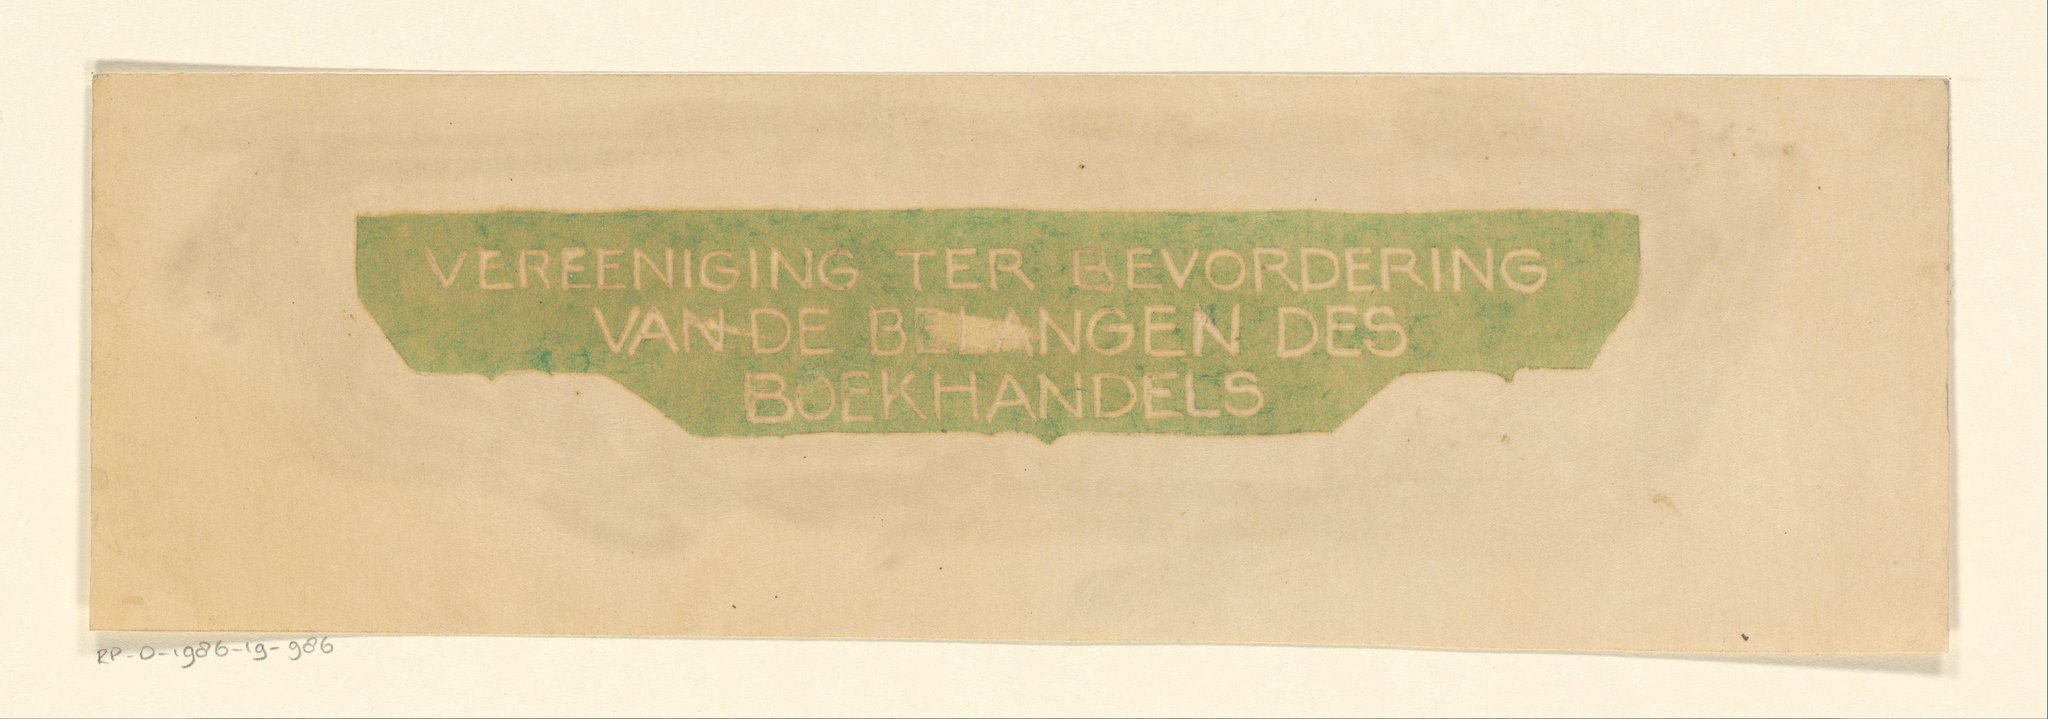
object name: print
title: Ontwerp voor een beeldmerk van de Vereniging ter Bevordering van de Belangen des Boekhandels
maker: reinier willem petrus de vries (1874-1953)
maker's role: draughtsman, print maker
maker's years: 1874-1953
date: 1884-1952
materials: paper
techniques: lithograph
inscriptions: collector's mark: ‘R:MVS.’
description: Beeldmerk bedoeld voor boven een kader van een oorkonde. Zie RP-D-1986-19-987.